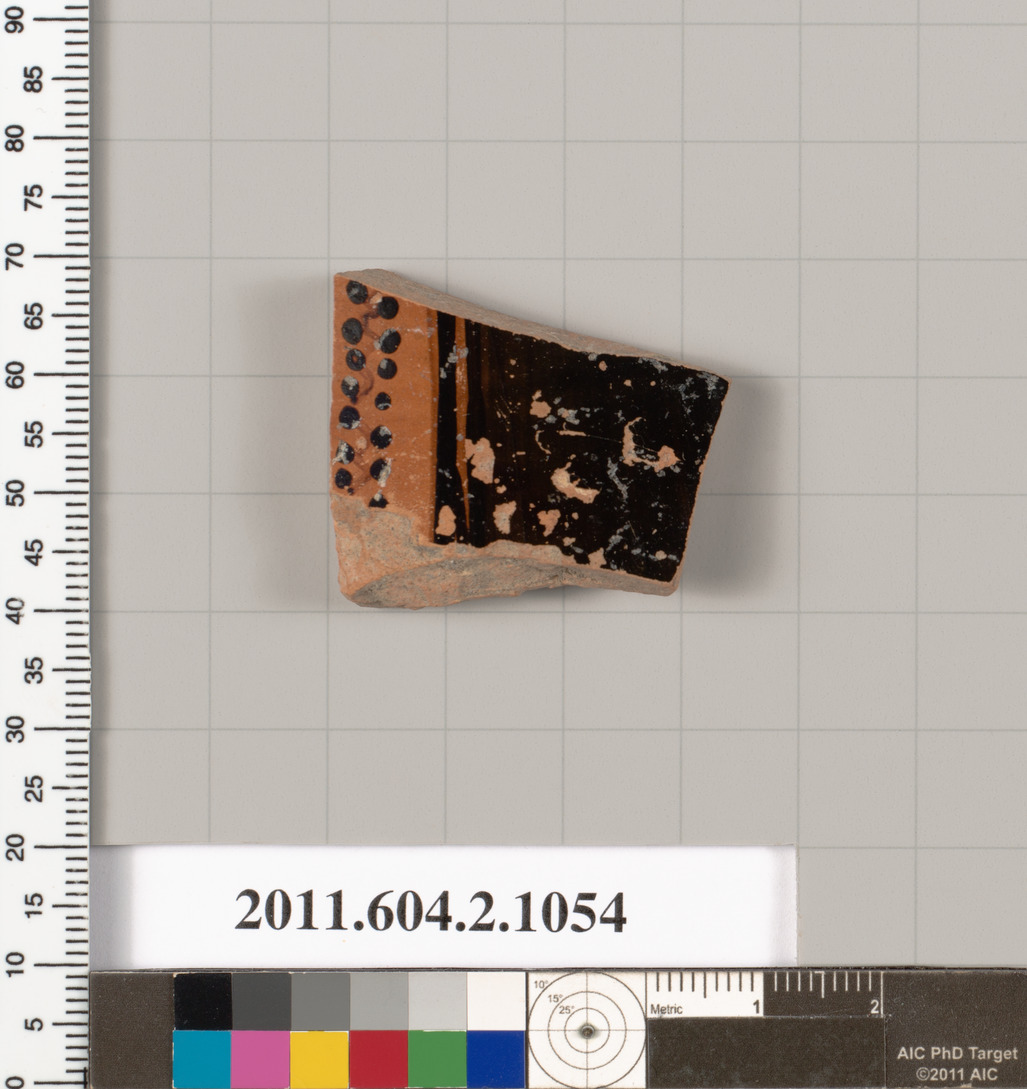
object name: pelike fragment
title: Terracotta fragment of a pelike (jar)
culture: greek, attic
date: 475-451 BCE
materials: terracotta